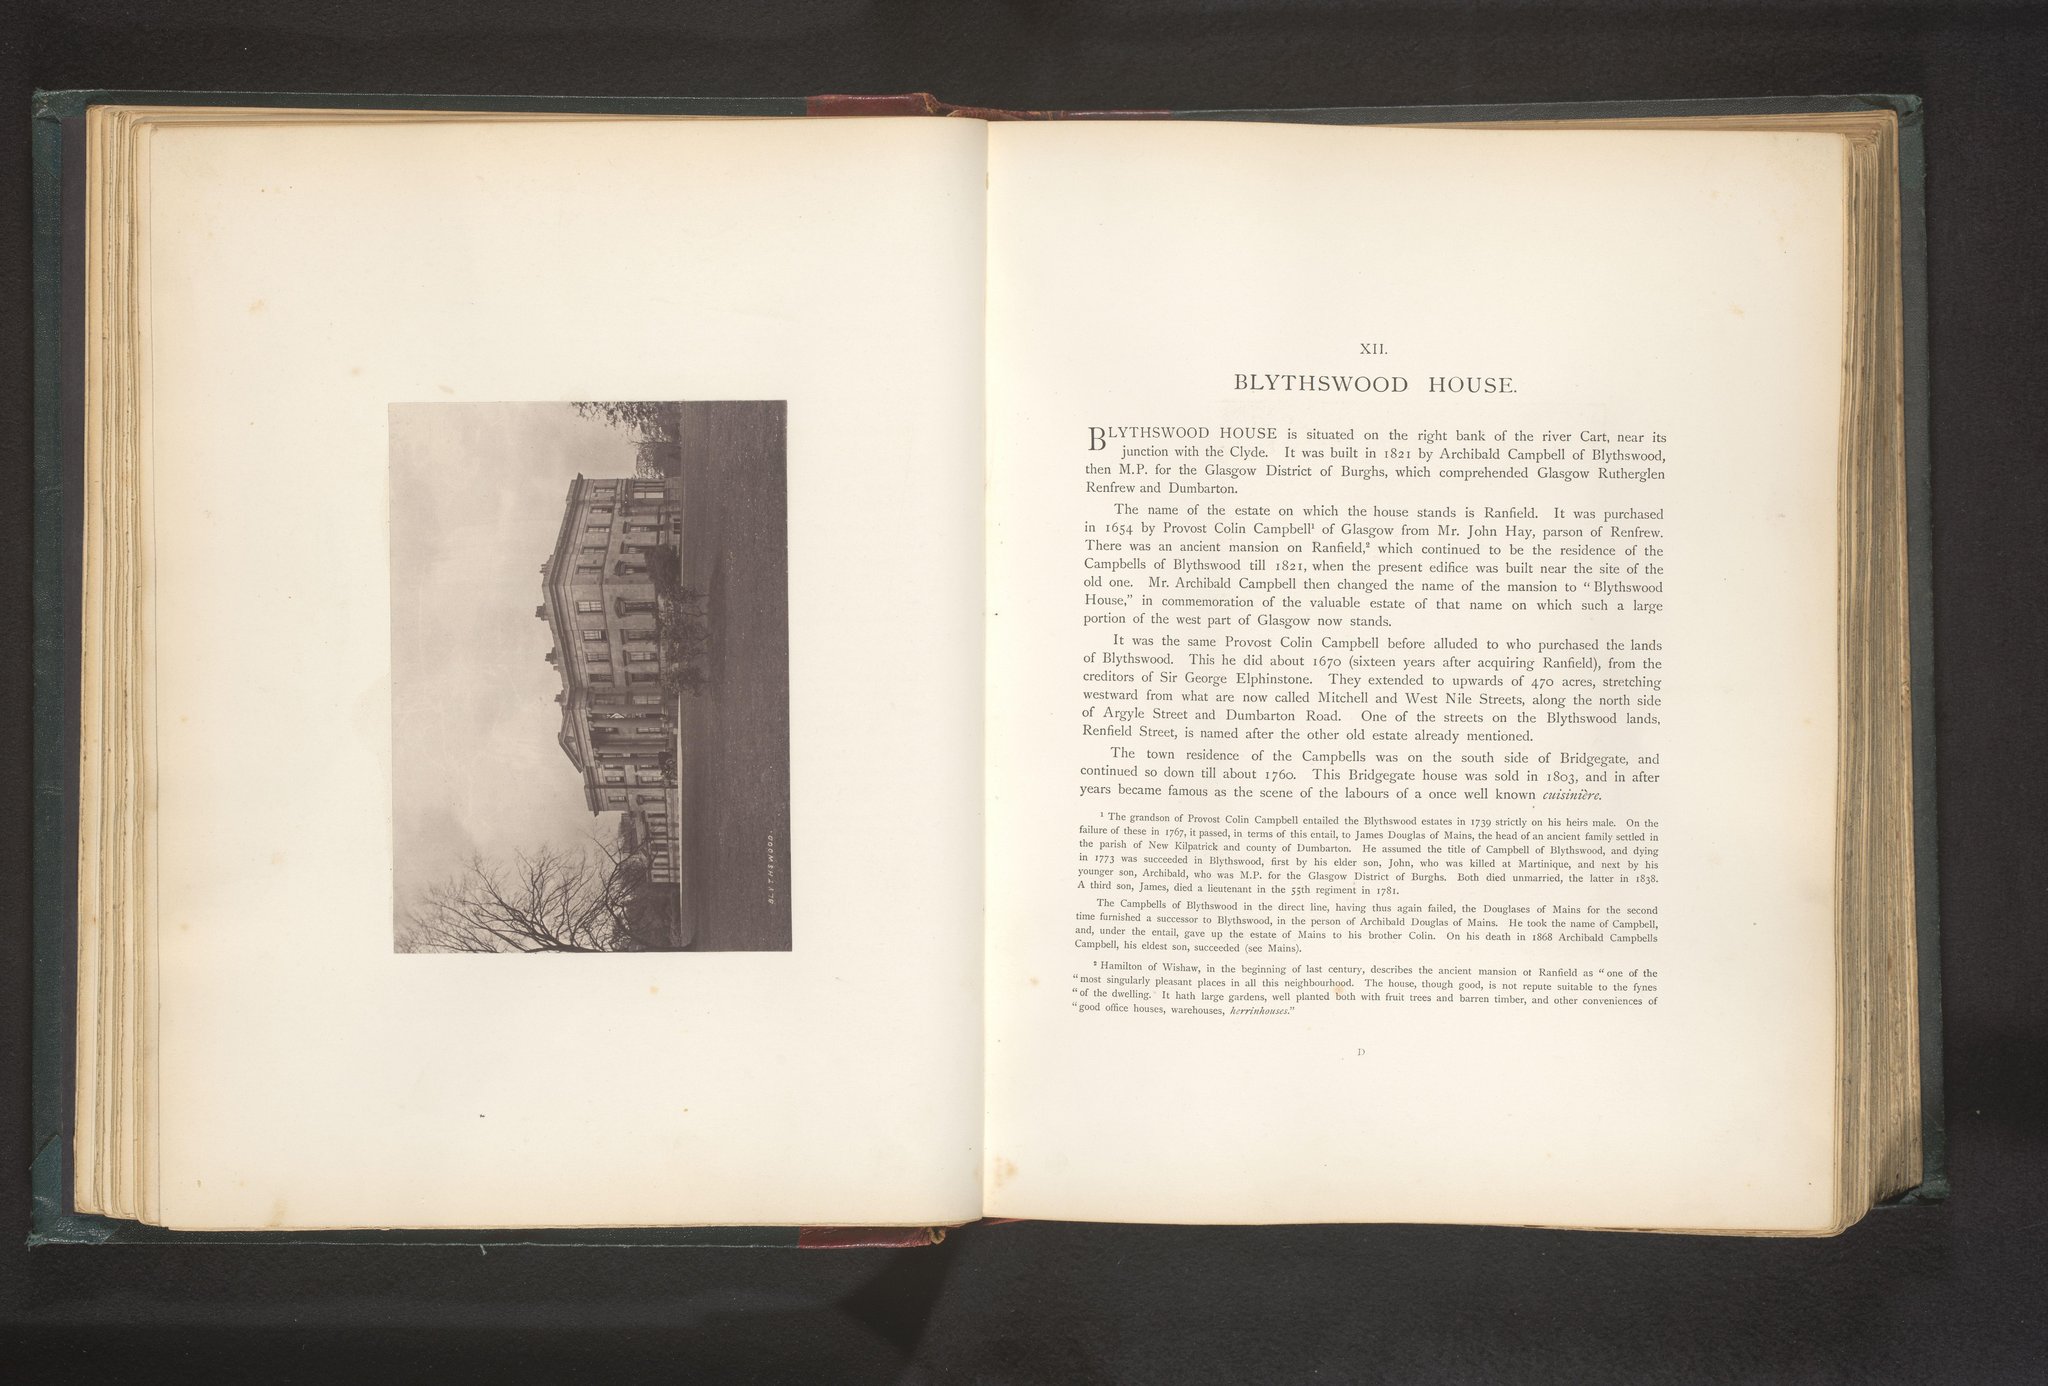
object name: page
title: Blythswood House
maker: thomas annan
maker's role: fotograaf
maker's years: 1829-1887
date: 1868-1878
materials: paper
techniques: carbon print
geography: glasgow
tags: rural housing, e.g. country-house, villa, cottage, façade (of house or building)